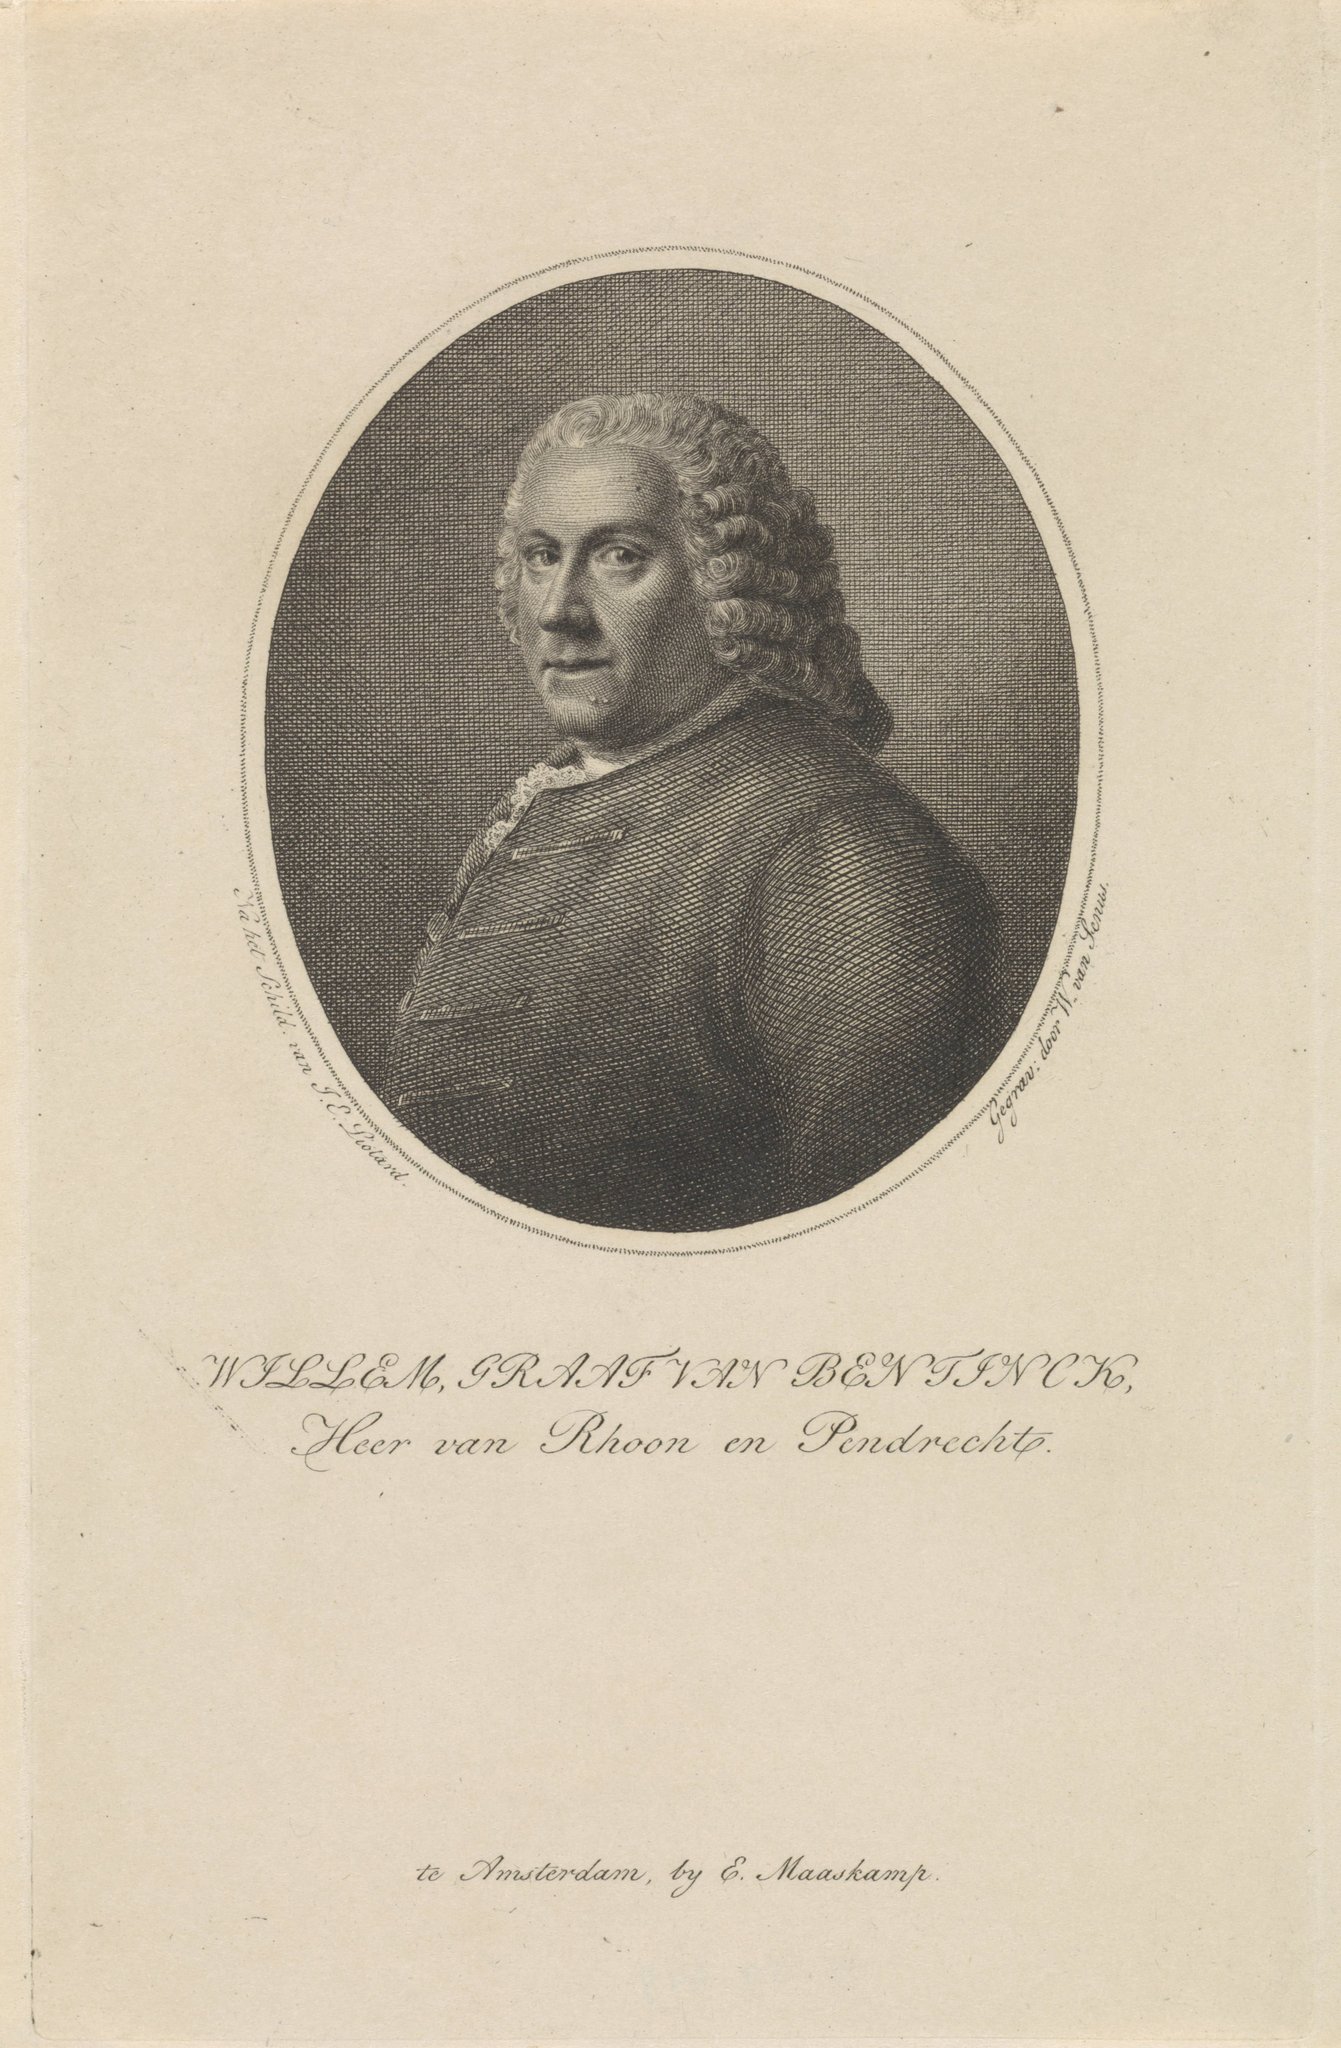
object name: print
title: Portret van Willem Gustaaf Frederik Bentinck van Rhoon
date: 1822-1826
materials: paper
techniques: engraving, etching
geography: amsterdam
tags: the hague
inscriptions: collector's mark: Lugt 2228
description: Prent gebruikt in: Stuart, Martinus. Vaderlandsche historie, vervattende de geschiedenissen der Vereenigde Nederlanden, van de vestiging van het Erfstadhouderschap in de mannelijke en vrouwelijke linie, tot aan 's Lands verlossing, uit de inlijving in het Fransche Keizerrijk. Amsterdam: Evert Maaskamp, 1822-1826.